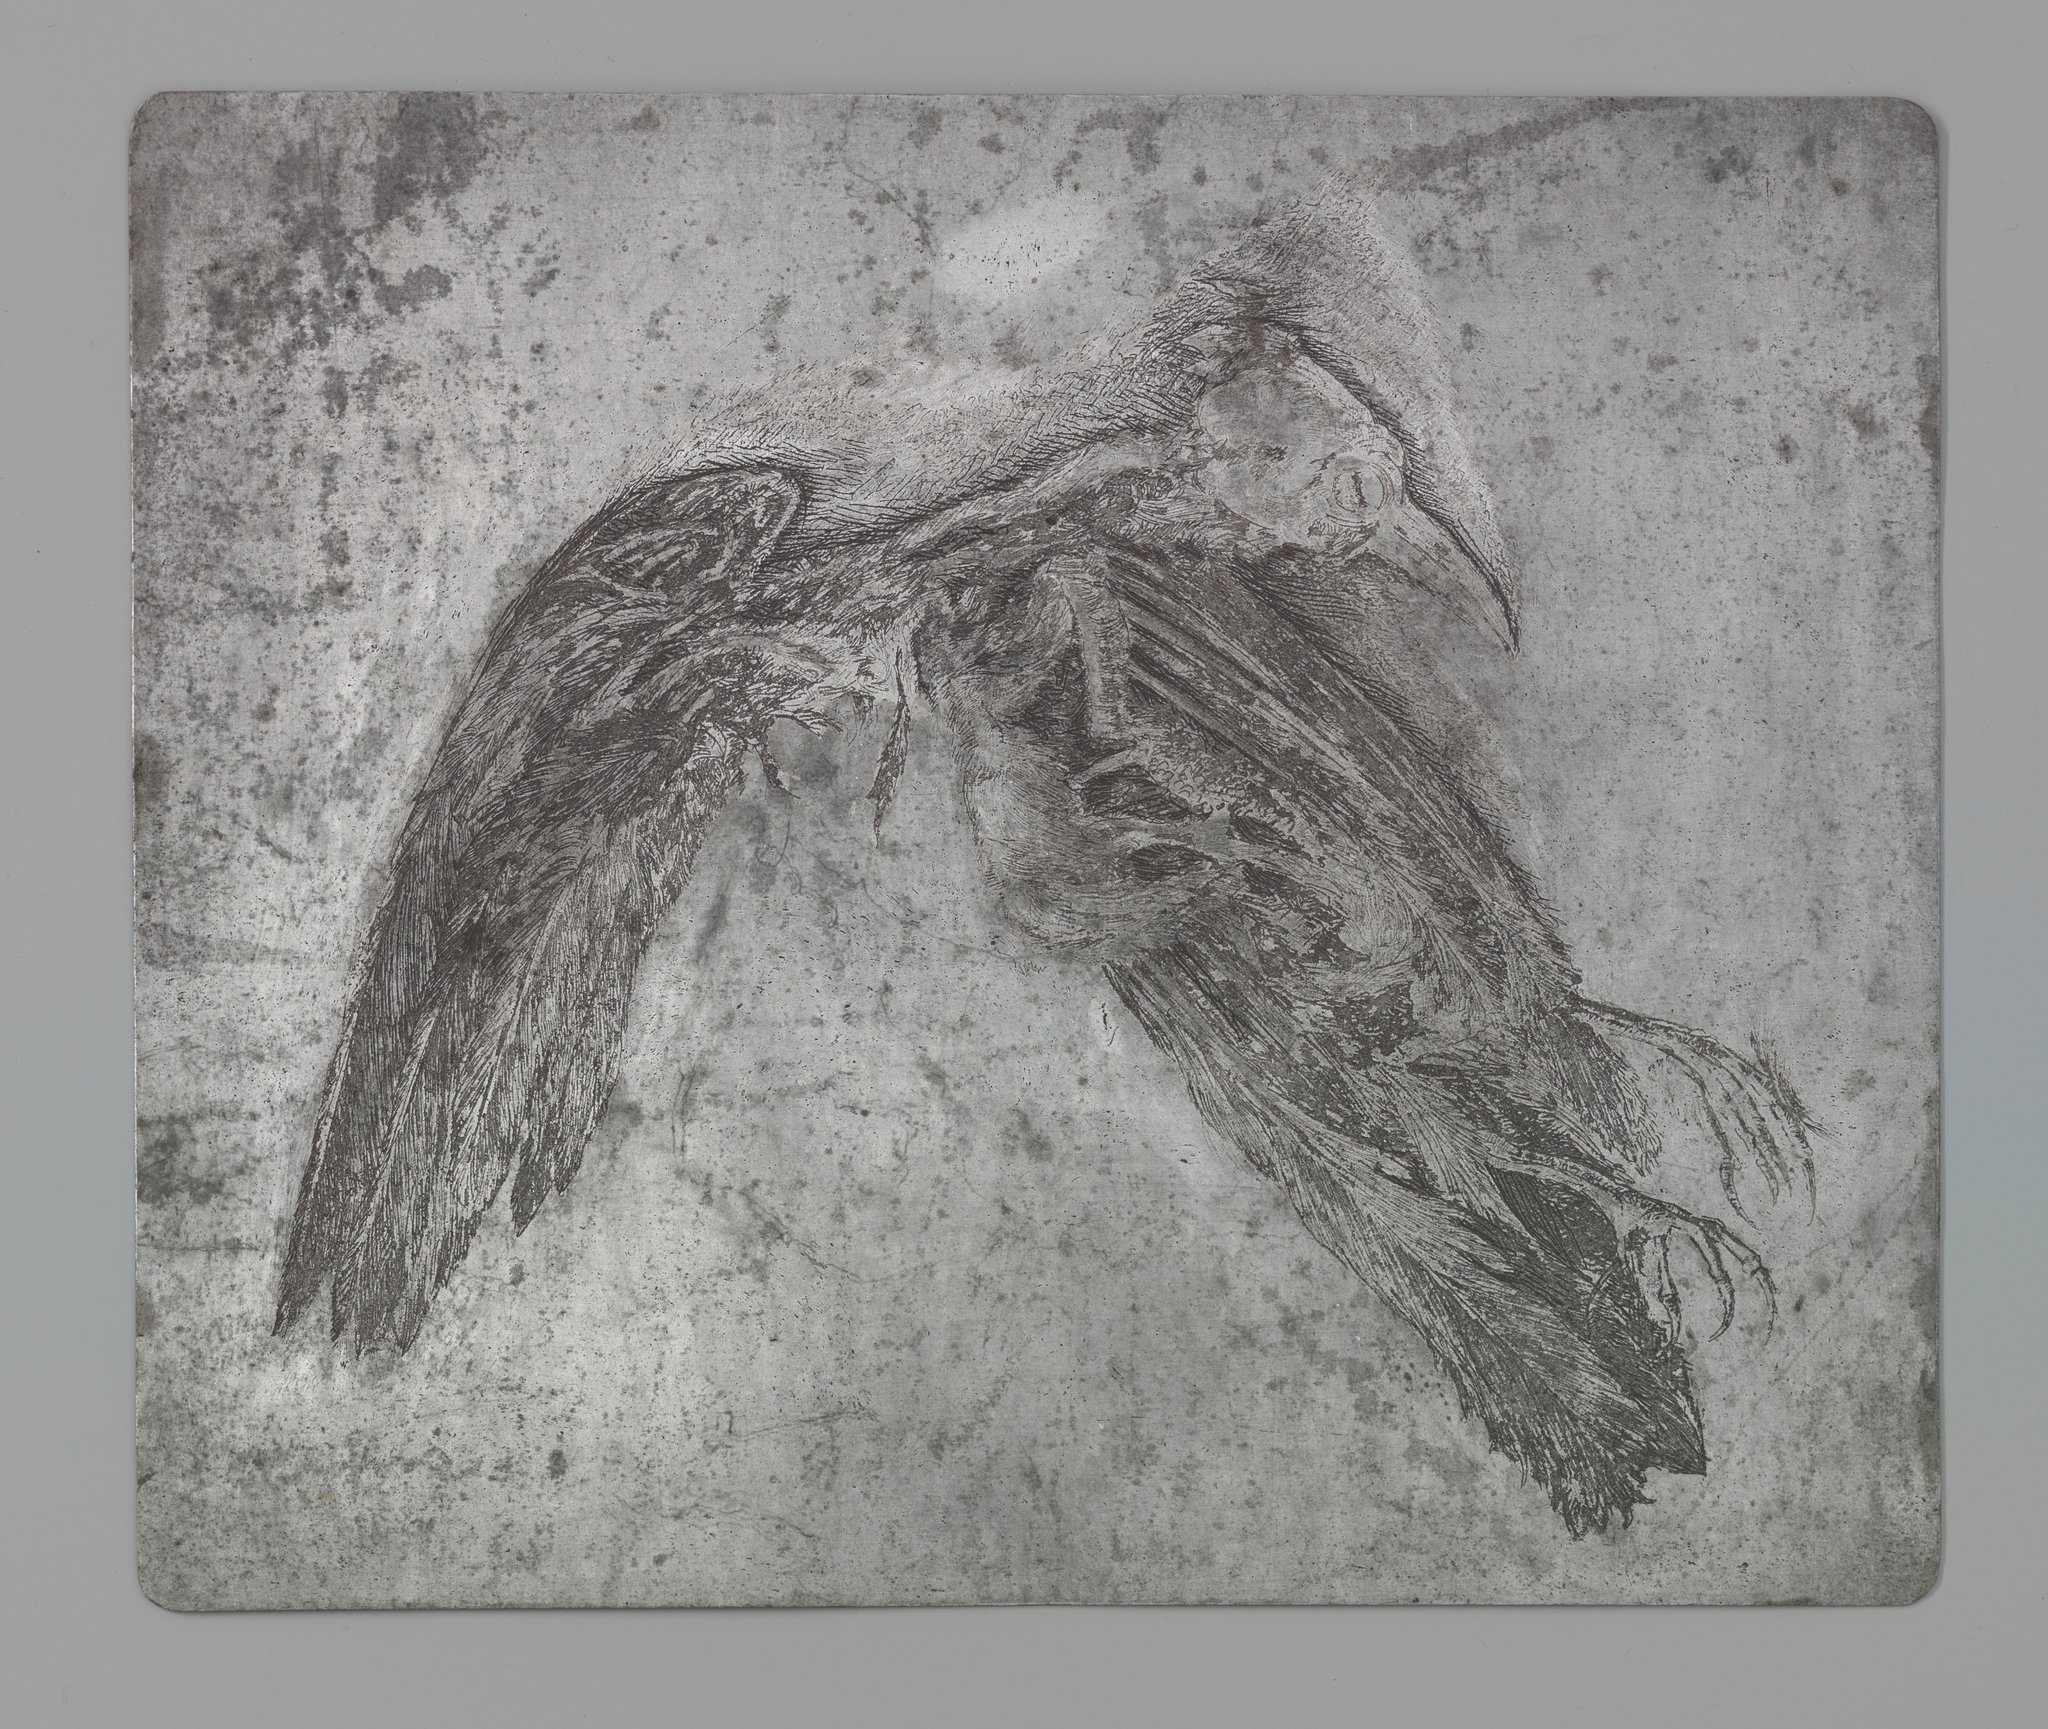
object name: zinkplaat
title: Dode vogel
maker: jan petrus ponstijn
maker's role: draughtsman, print maker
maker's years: 1883-1970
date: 1940-1948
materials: zinc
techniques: etching